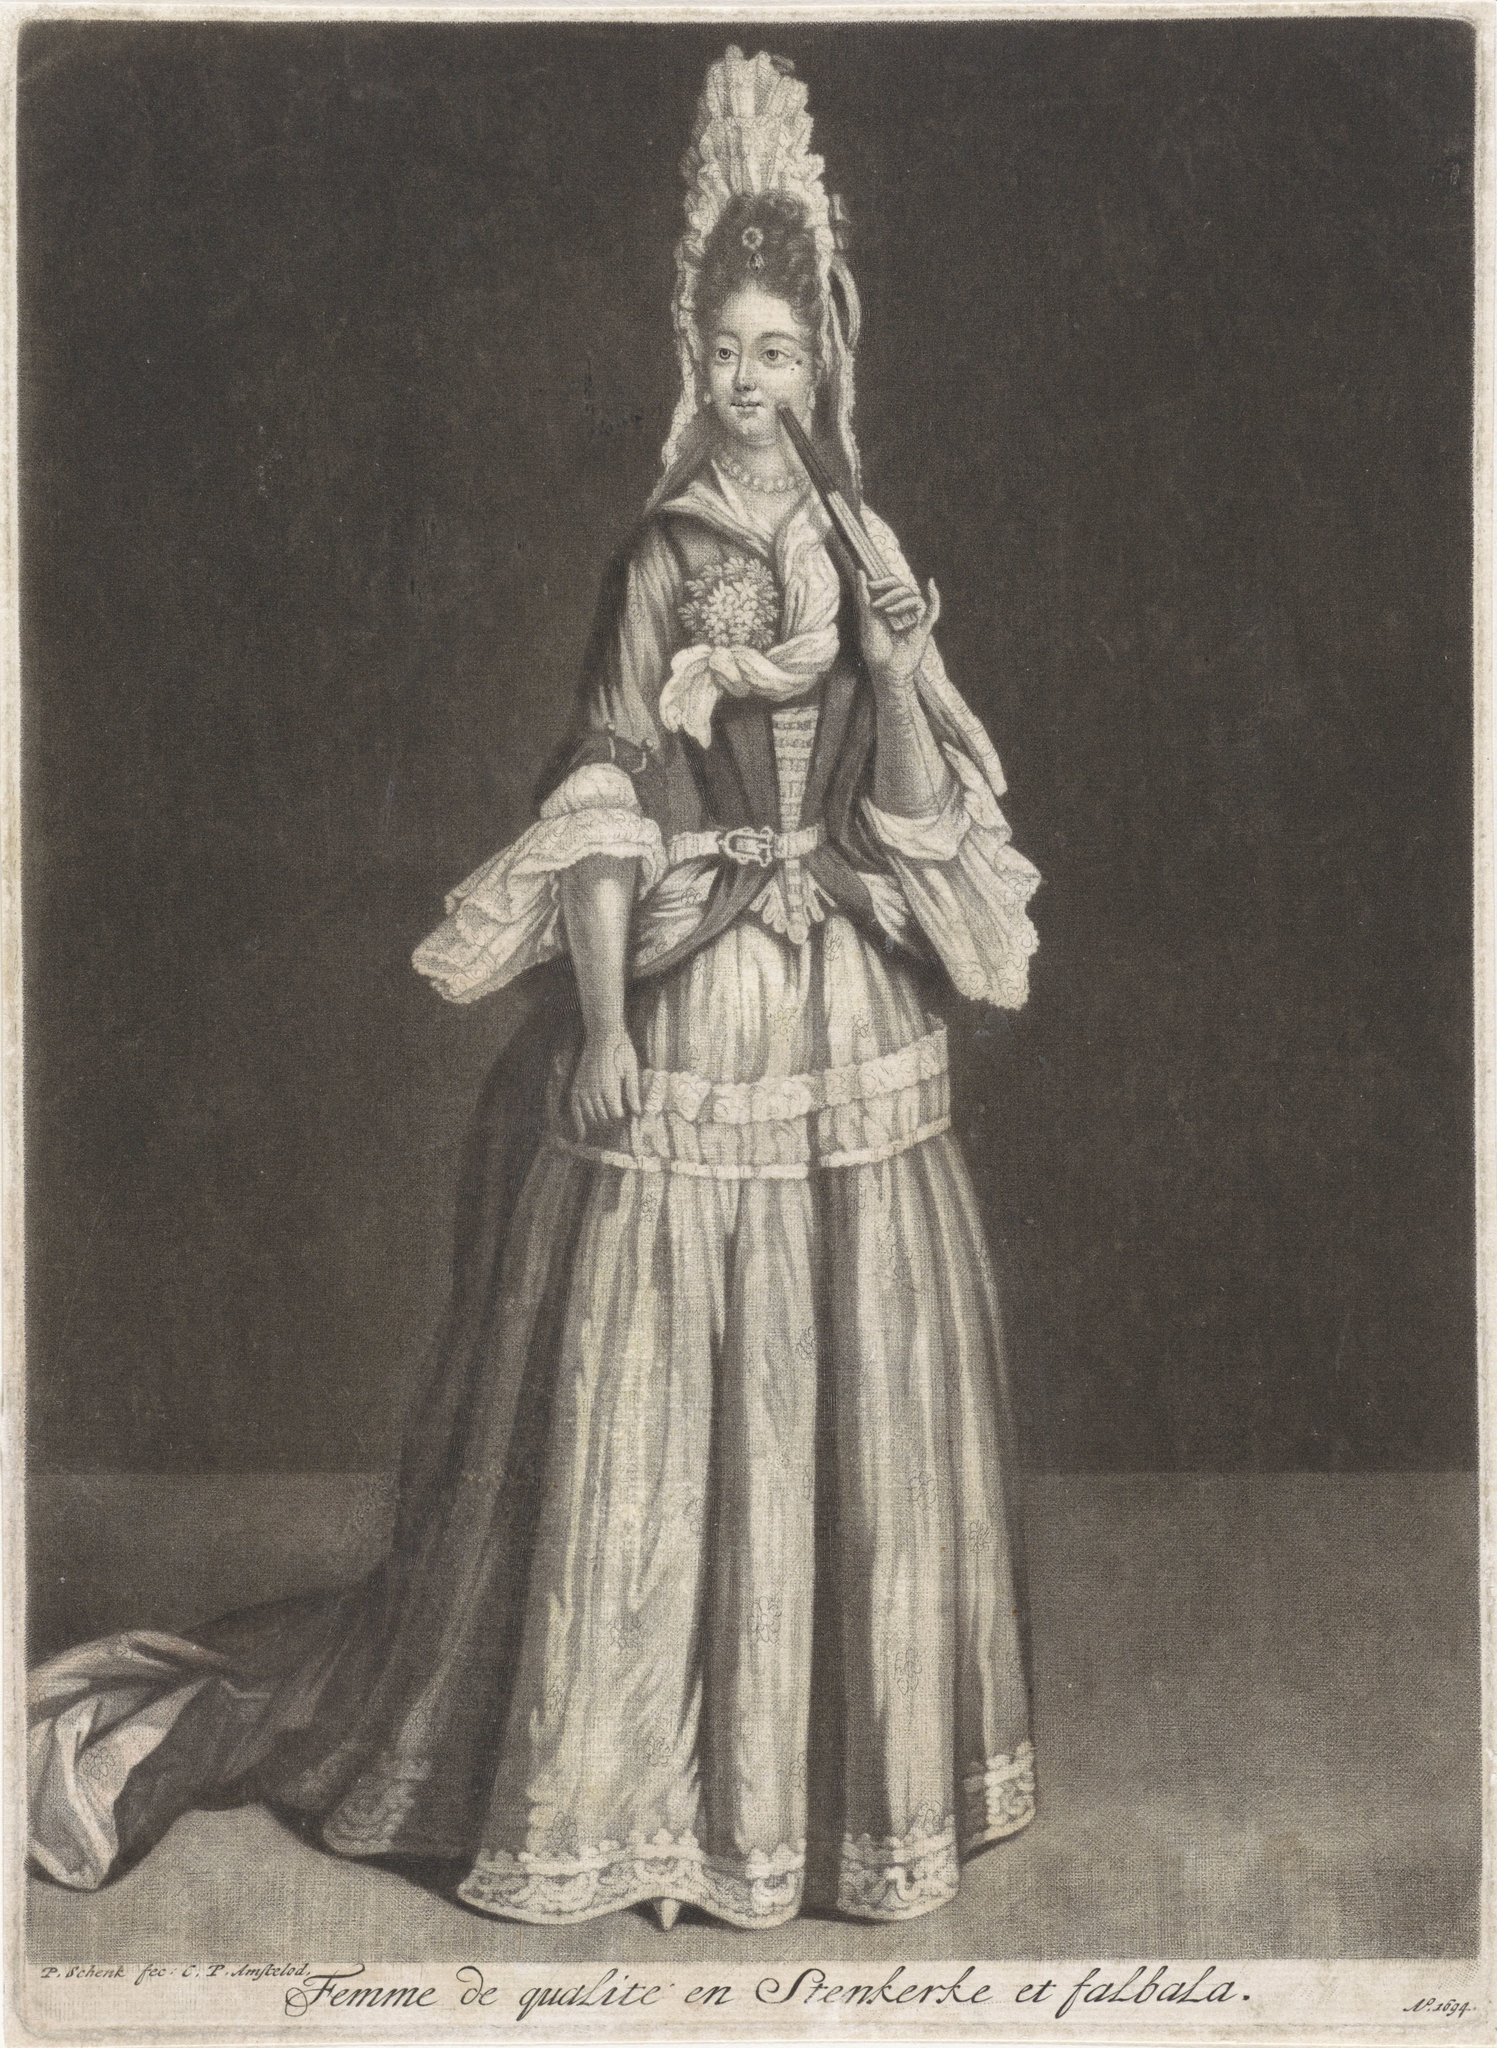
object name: costume print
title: Femme de qualité en Stenkerke et falbala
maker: pieter schenk (i)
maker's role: print maker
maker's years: 1660-1711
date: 1694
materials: paper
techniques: engraving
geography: amsterdam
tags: styles of hairdress (with name) - aa - ~ women, neck-gear ~ clothing (stenkerke) (+ women's clothes), fashion plates, clothes, costume (+ women's clothes), dress, gown (+ women's clothes), head-gear: fontange (+ women's clothes), dress, gown: manteau (+ women's clothes), painting of body or face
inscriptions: collector's mark: Lugt 2228, title: ‘Femme de qualité en Stenkerke et falbala’, date:, signature: ‘P. Schenk fec.’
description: Staande vrouw met in de hand een waaier. Zij is gekleed volgens de mode van eind 17de eeuw en draagt een fontange kapsel. De sjaal (cravat) is à la Stenkerke vastgemaakt.